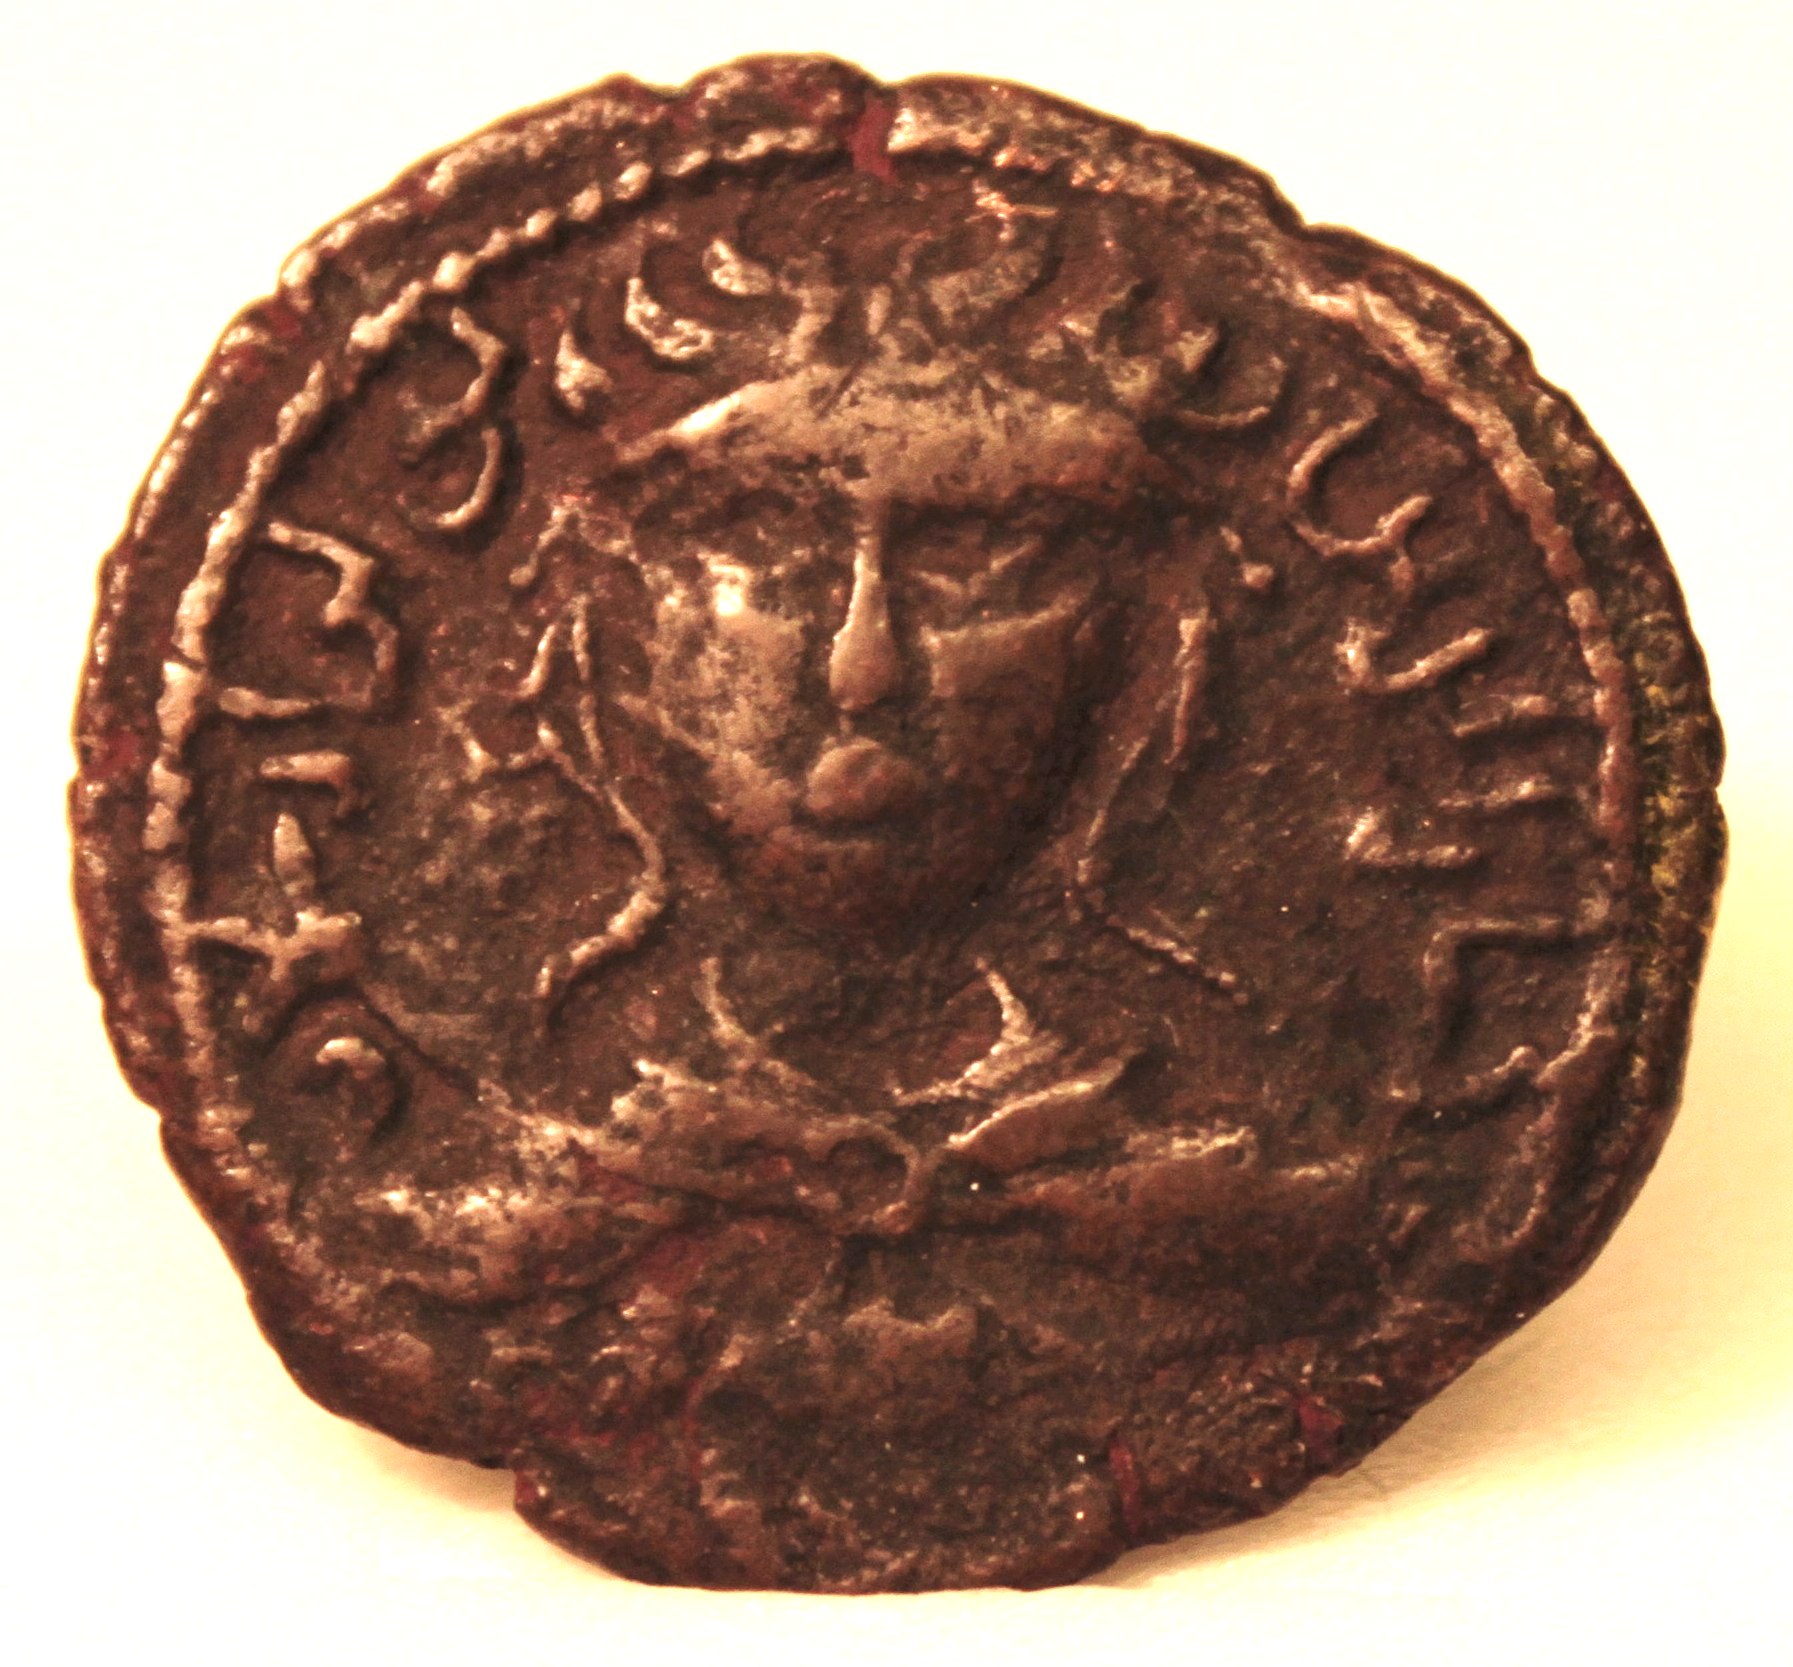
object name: coin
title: Dirham of Husain al-Din Yuluk Arslan (r. 1184–1200)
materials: copper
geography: turkey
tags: faces